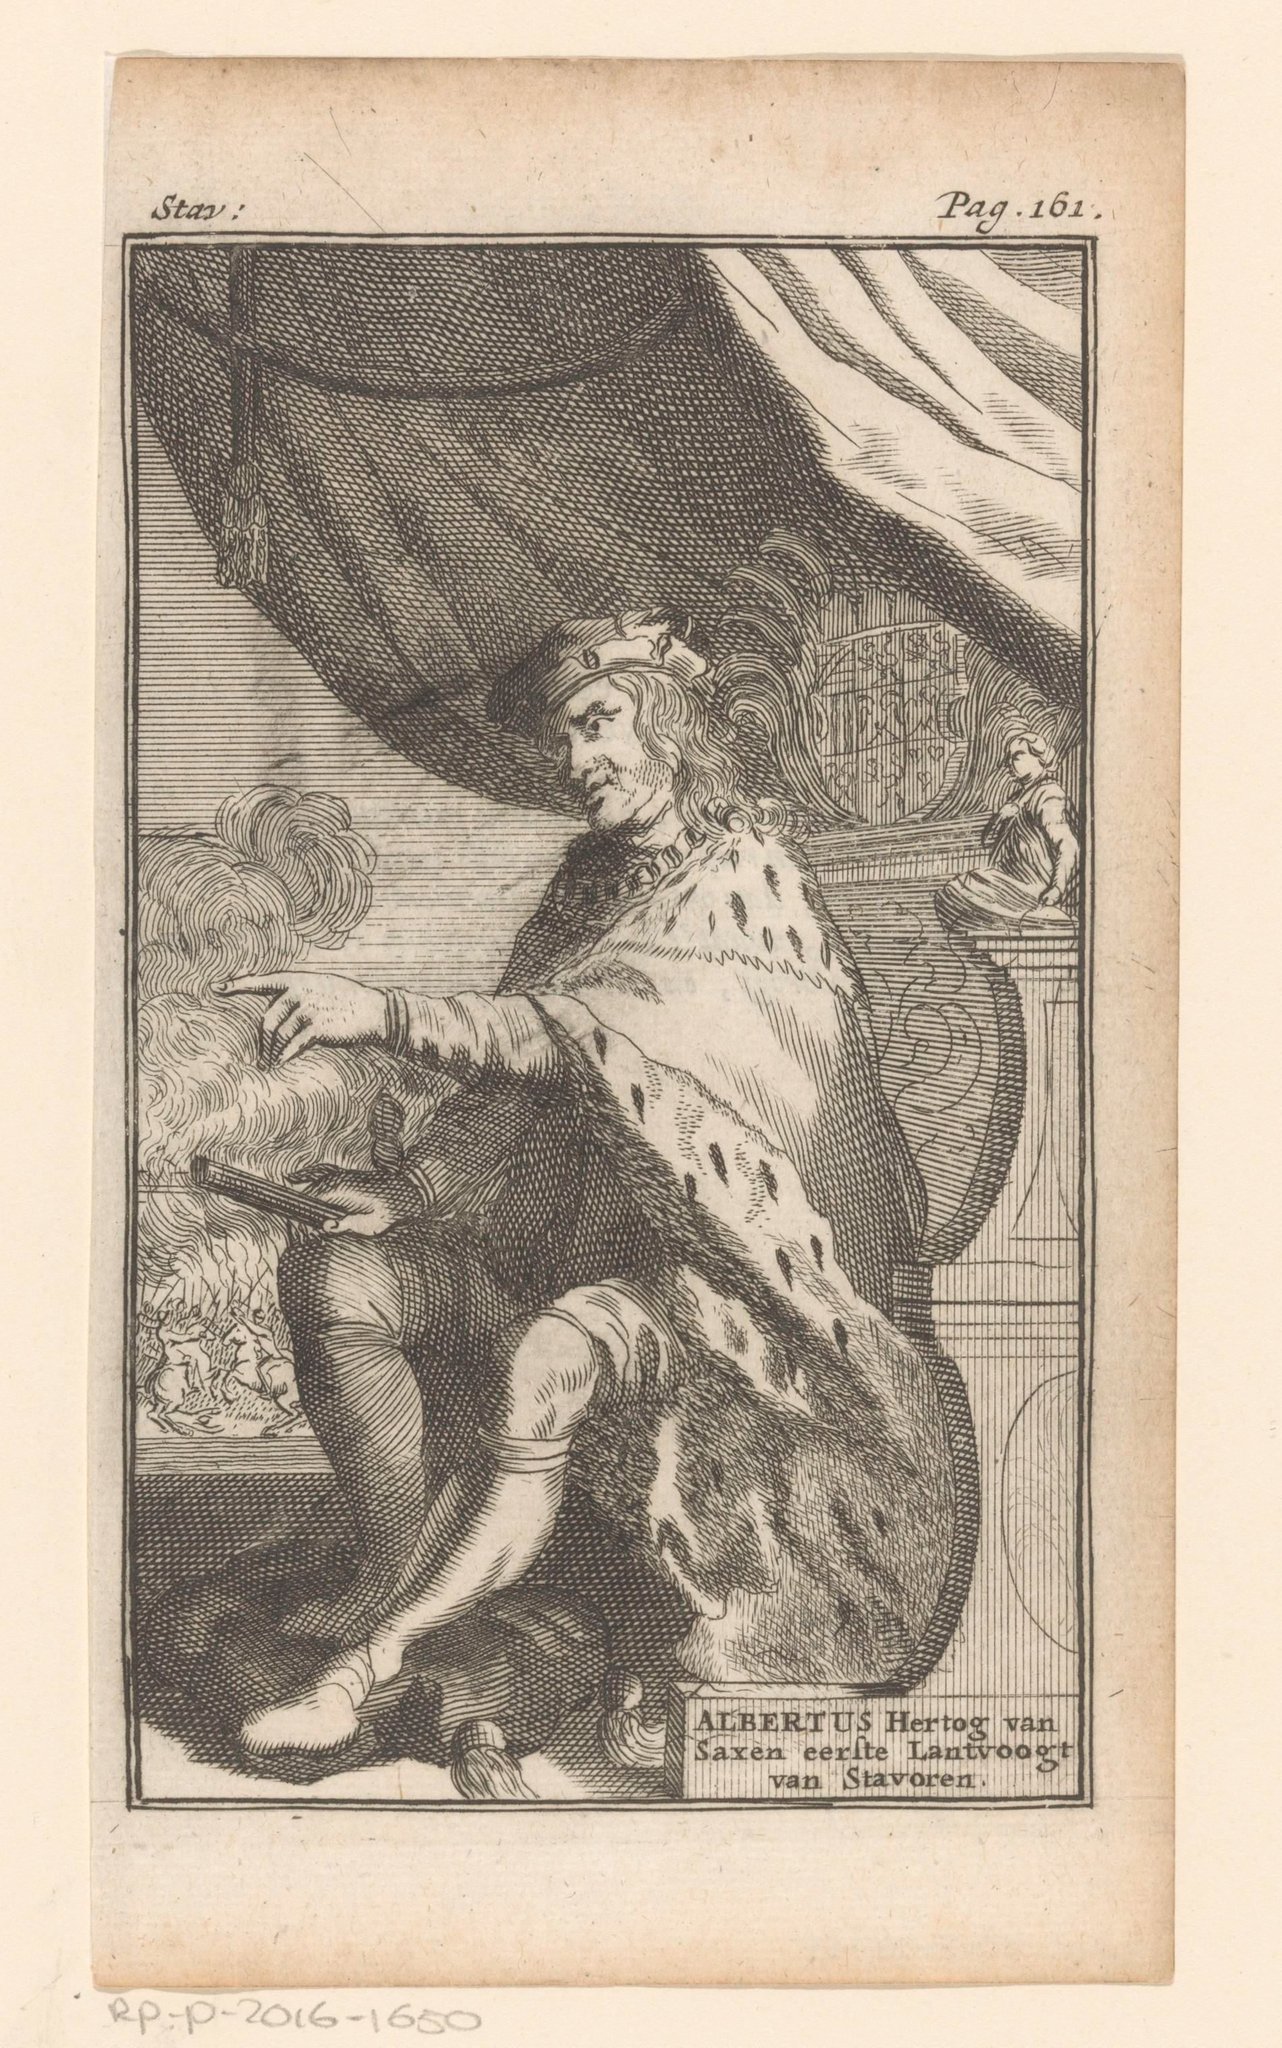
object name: print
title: Portret van Albrecht III, hertog van Saksen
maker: Anonymous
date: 1600-1699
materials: paper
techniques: engraving, etching, letterpress printing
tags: emden, hertog, albrecht de kloekmoedige (hertog van saksen)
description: Linksboven: Stav:. Rechtsboven: Pag. 161.